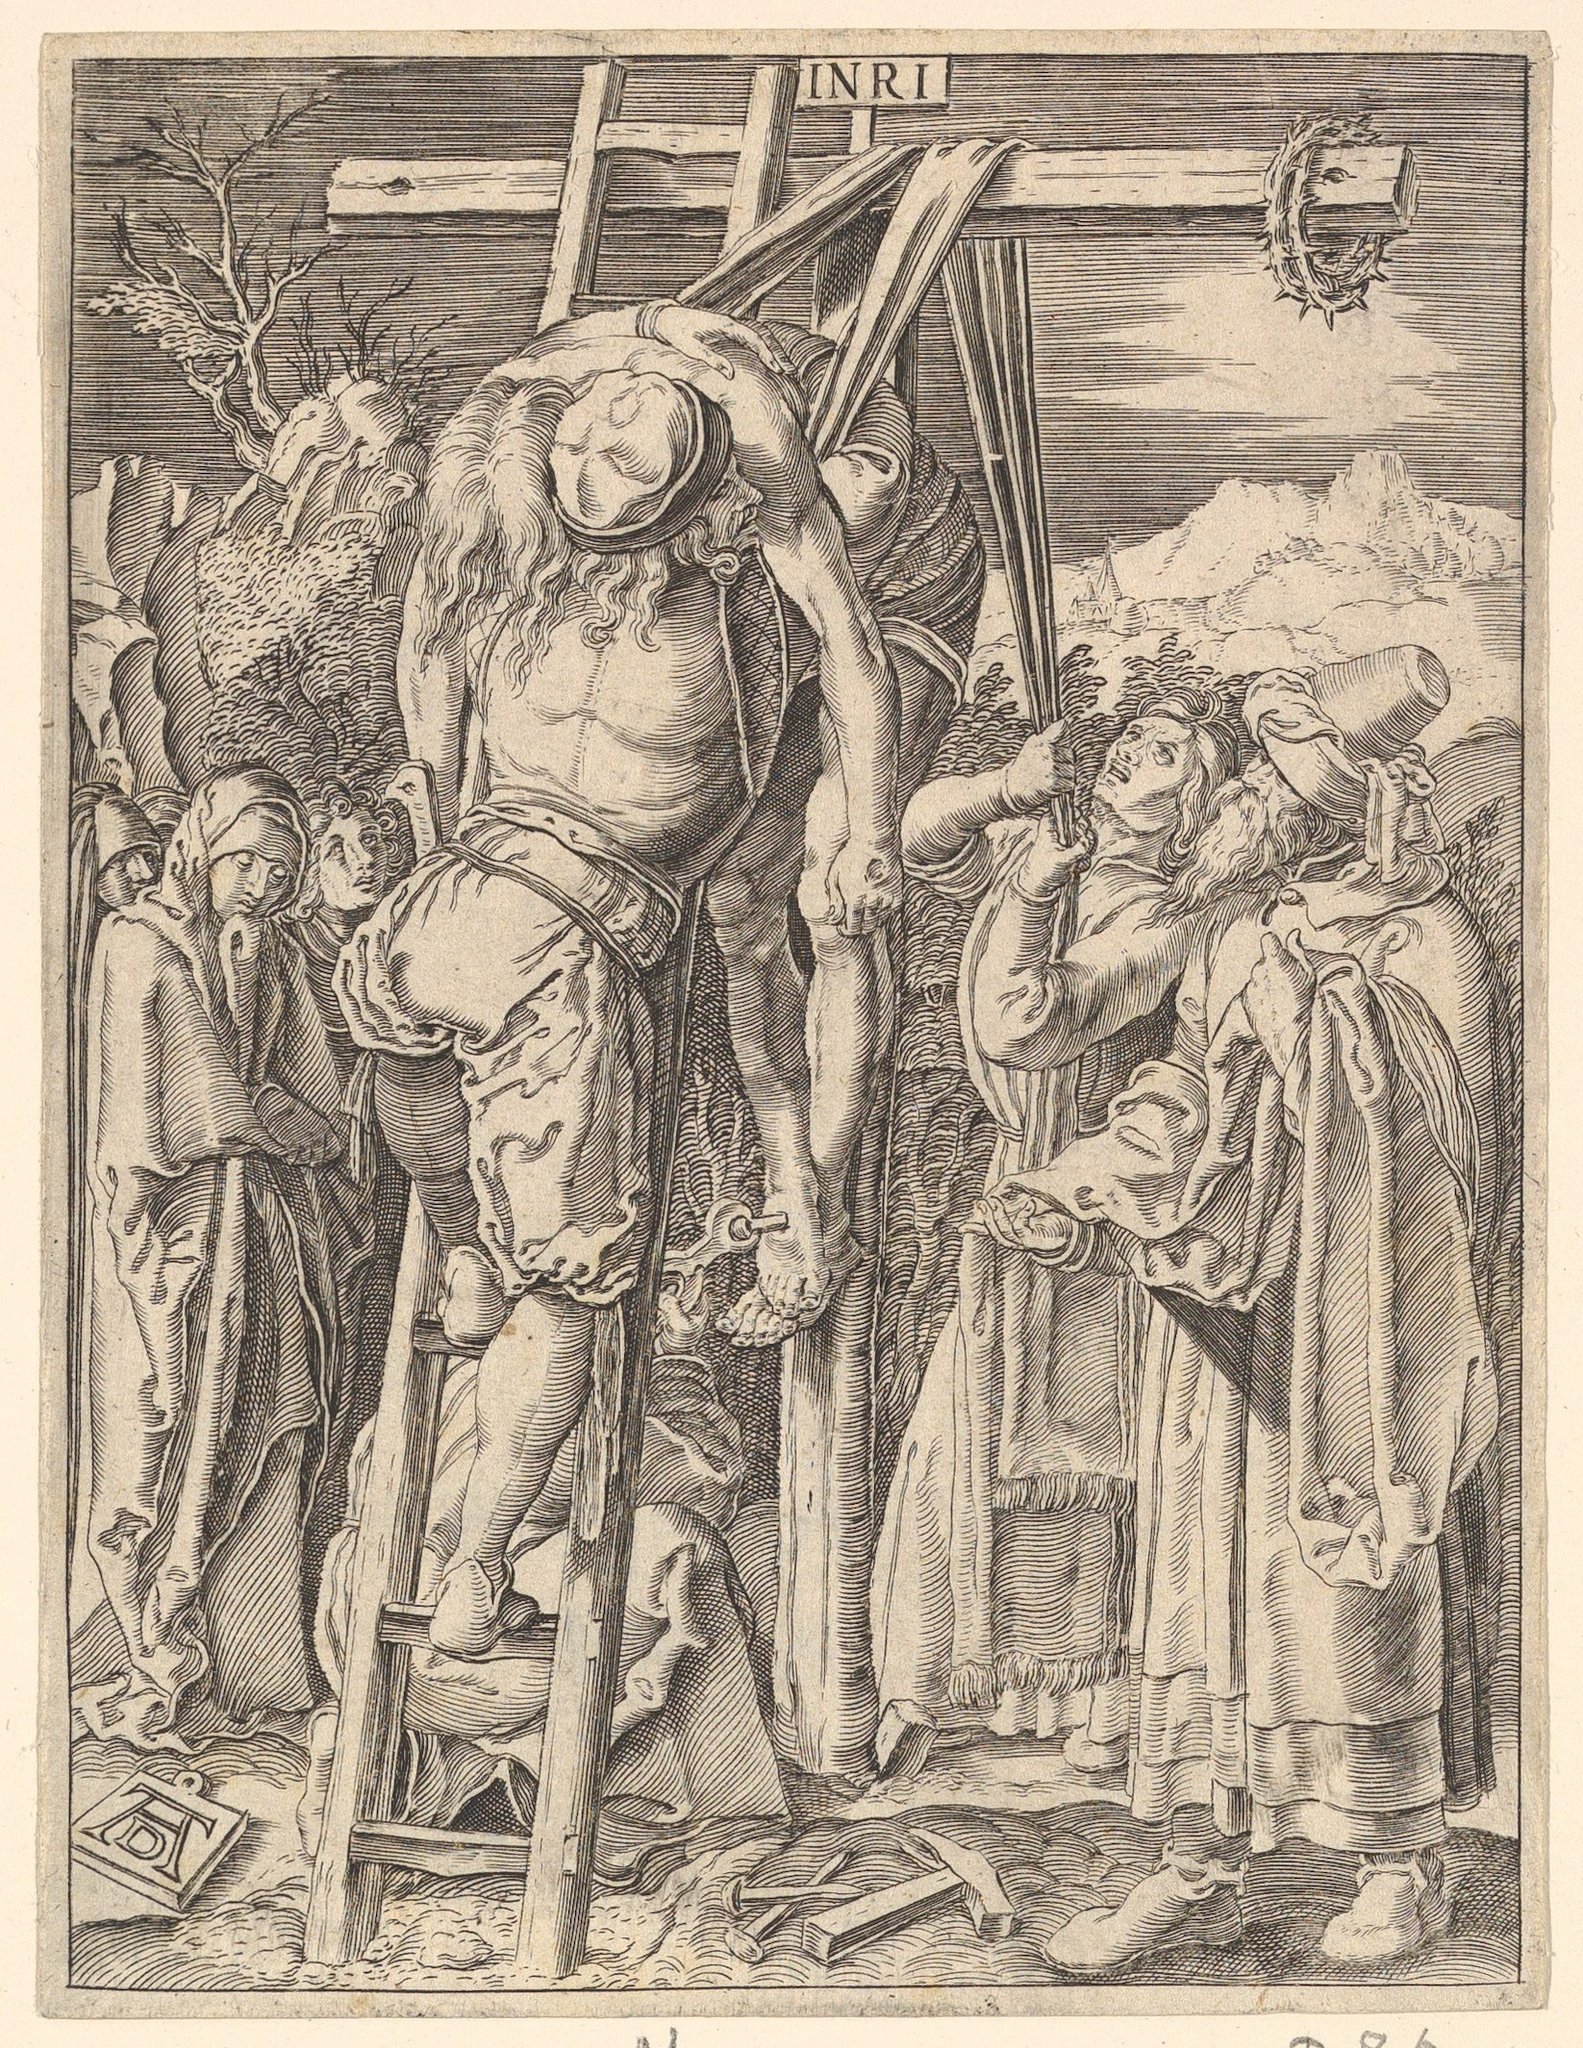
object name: print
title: Engraved copies of The Little Passion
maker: albrecht dürer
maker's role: artist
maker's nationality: german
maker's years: 1471-1528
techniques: engraving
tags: men,women,christ,cross